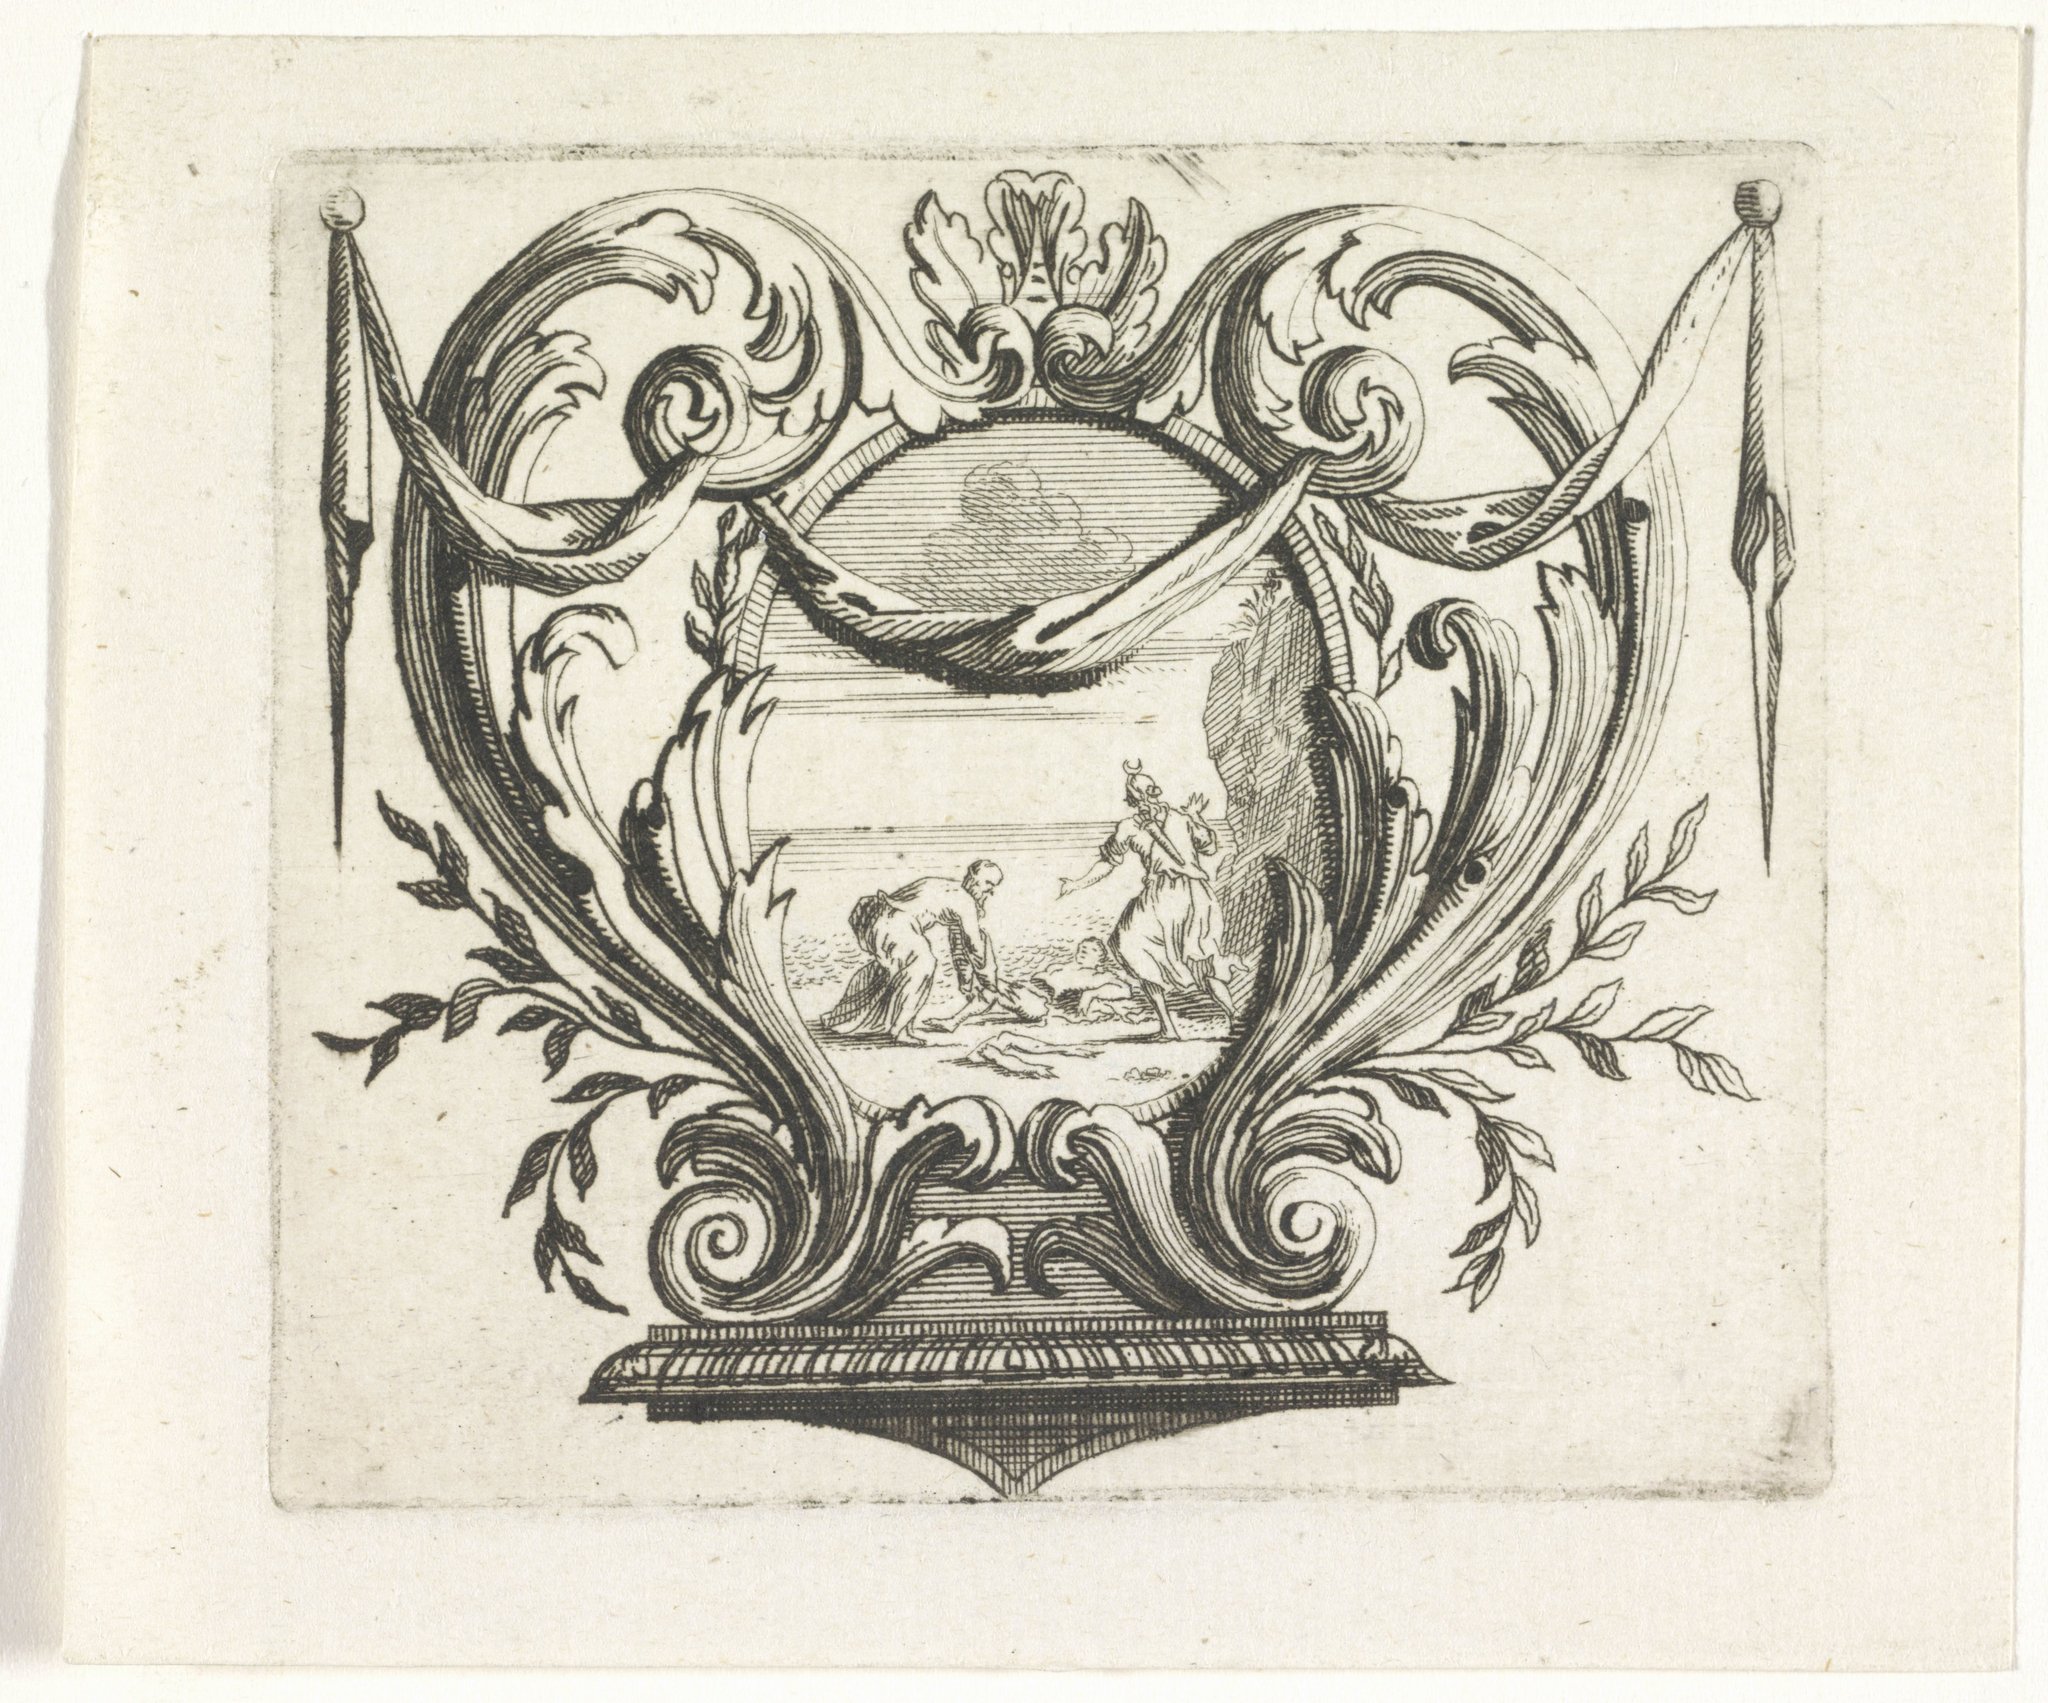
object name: print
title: Vignet met de godin Diana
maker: Anonymous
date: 1700-1800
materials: paper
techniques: etching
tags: (story of) diana (artemis), legs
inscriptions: collector's mark: Lugt 2228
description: Vignet met een voorstelling waarbij de godin Diana verschrikt op een strand staat bij een man wiens been niet meer aan zijn romp zit. Een man houdt het been vast. Op de voorgrond liggen andere ledematen. Rond de voorstelling ornament en bladranken.